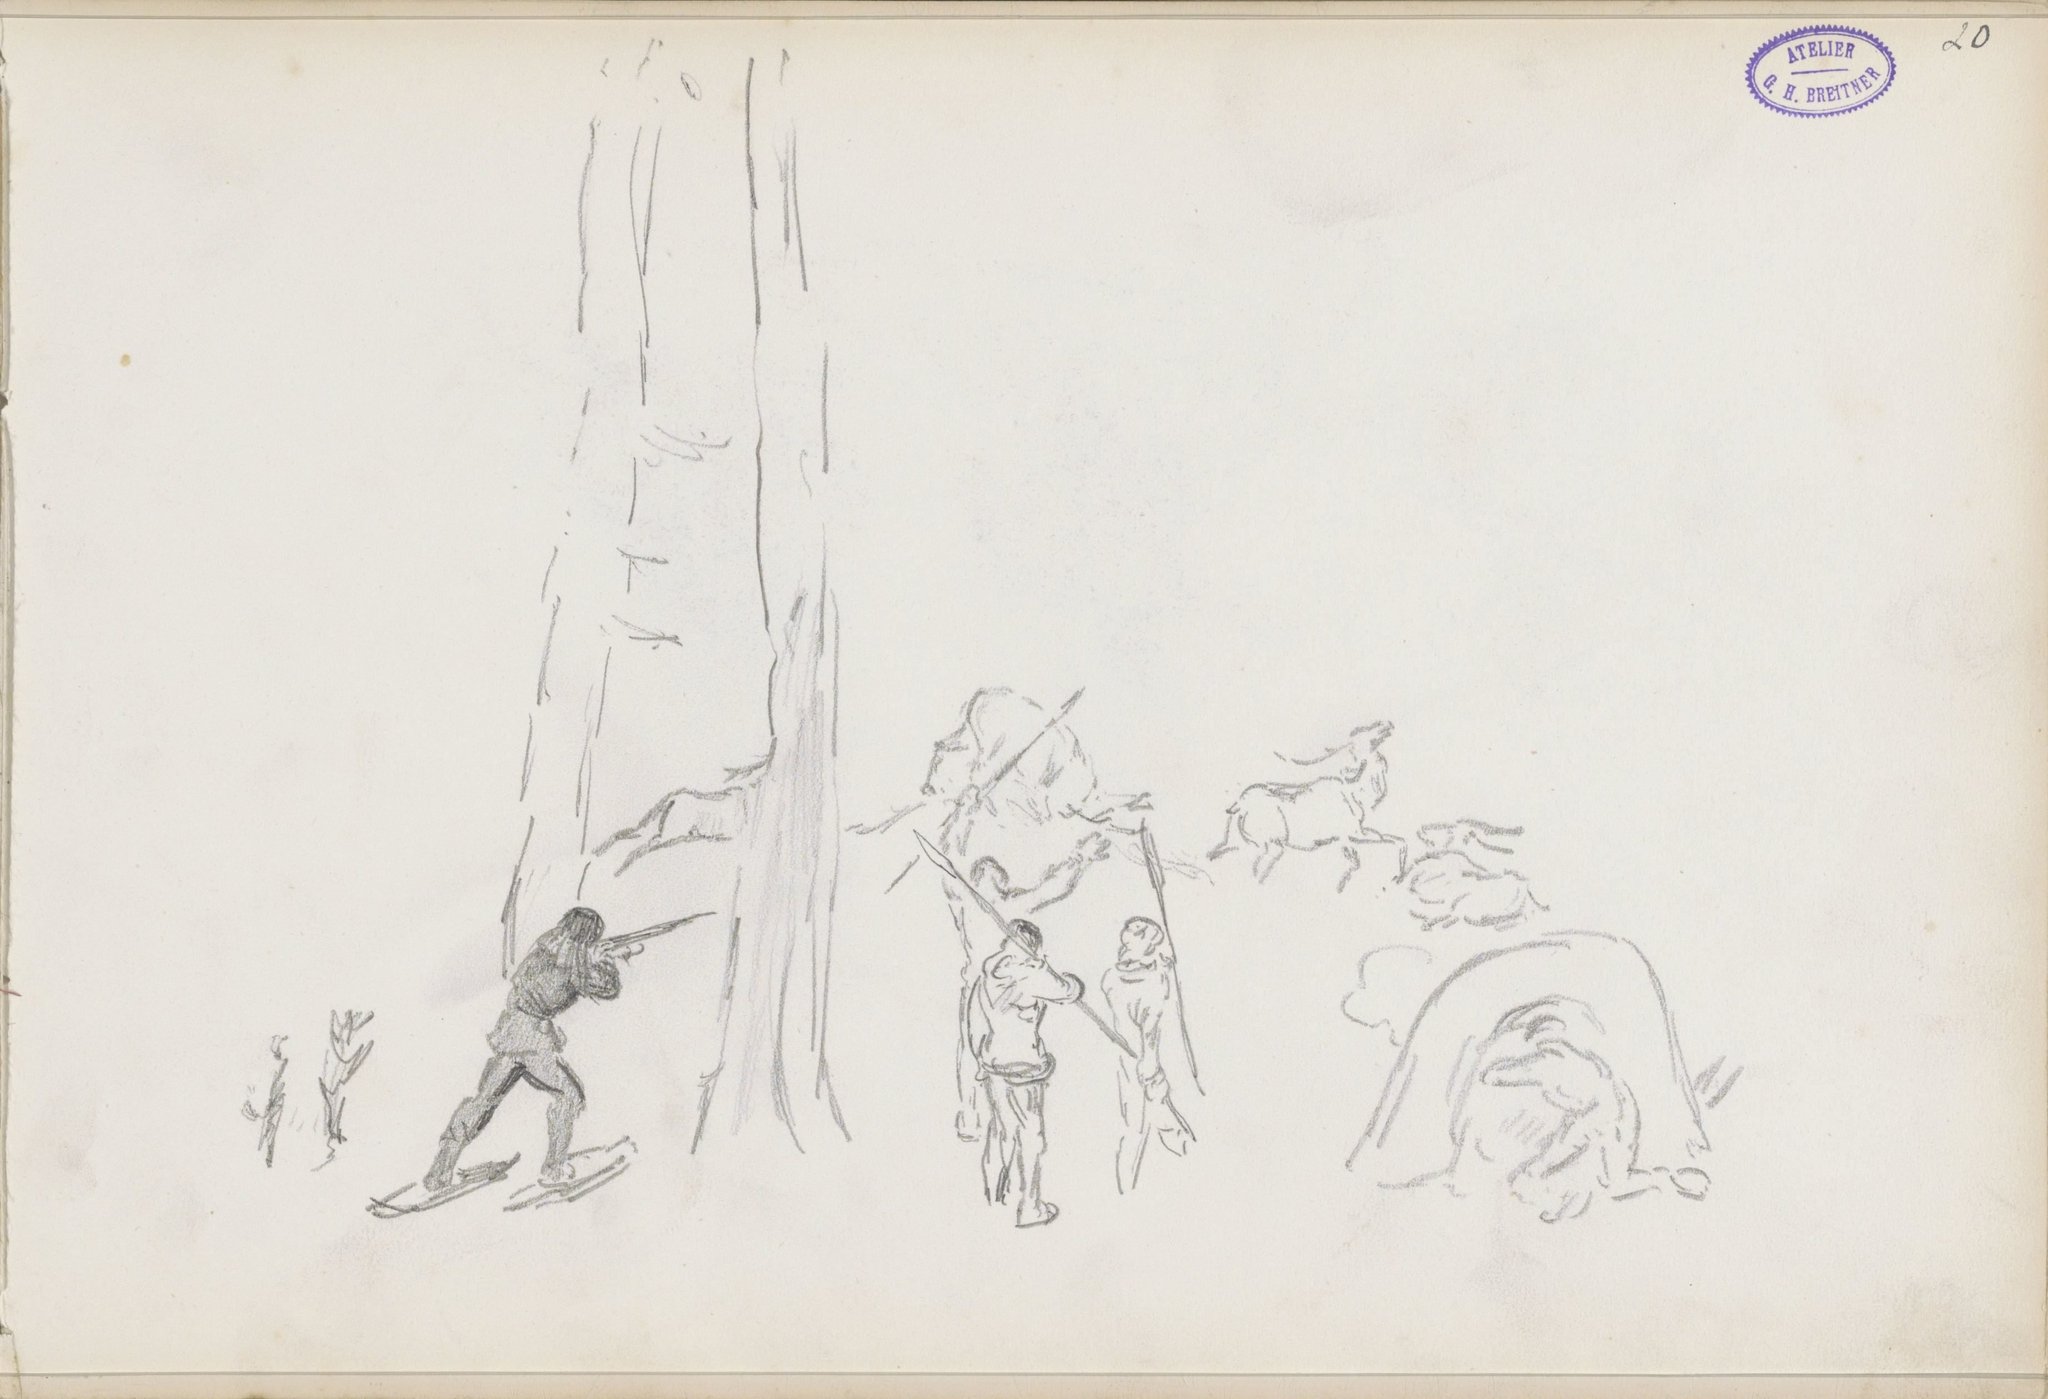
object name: sketchbook leaf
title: Soldaat met een getrokken geweer en mannen met speren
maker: george hendrik breitner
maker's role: draughtsman, painter, print maker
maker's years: 1857-1923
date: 1809-1872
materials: paper, pencil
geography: rotterdam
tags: mammals, division of armed forces (+ land forces), casting weapons: spear, firearms: rifle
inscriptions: workshop stamp: Lugt 291d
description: De soldaat staat achter een boom en draagt sneeuwschoenen. Op de achtergrond rennen dieren. Blad 20 recto uit een schetsboek met 32 bladen.